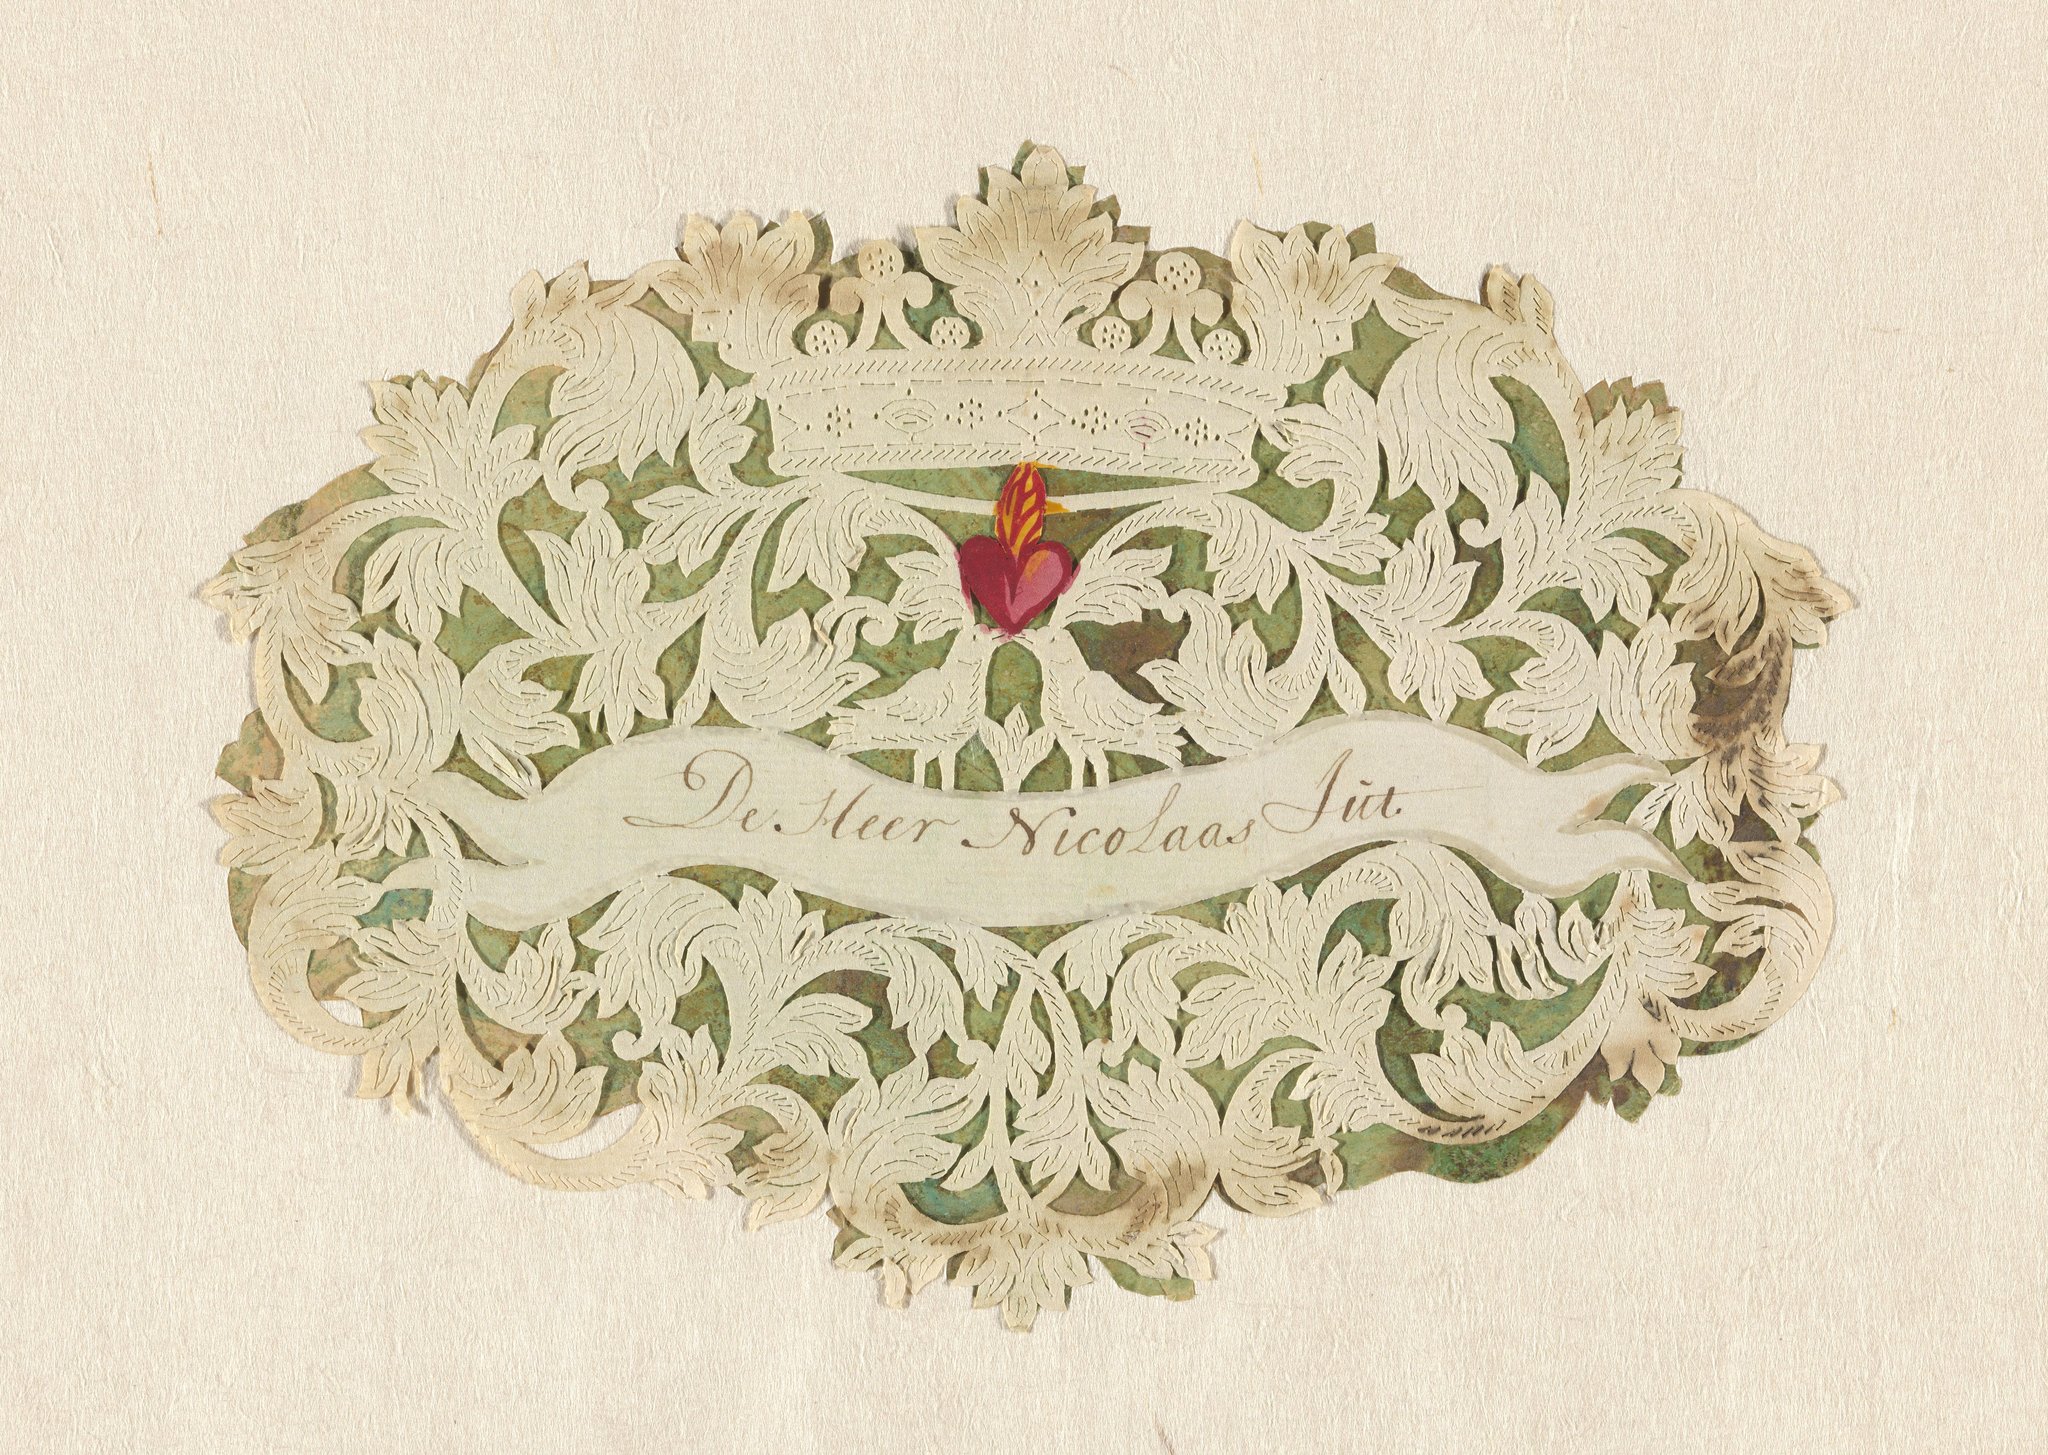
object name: cut paper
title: Huwelijksknipsel voor gast Nicolaas Jut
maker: Anonymous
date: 1753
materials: ink, paper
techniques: cutting, hand coloring, snipping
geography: netherlands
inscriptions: inscription: ‘De heer Nicolaas Jut’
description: Huwelijksknipsel voor bruidegom Nicolaas Jut. Ornament met kroon, vogels en sierlijk loofwerk.